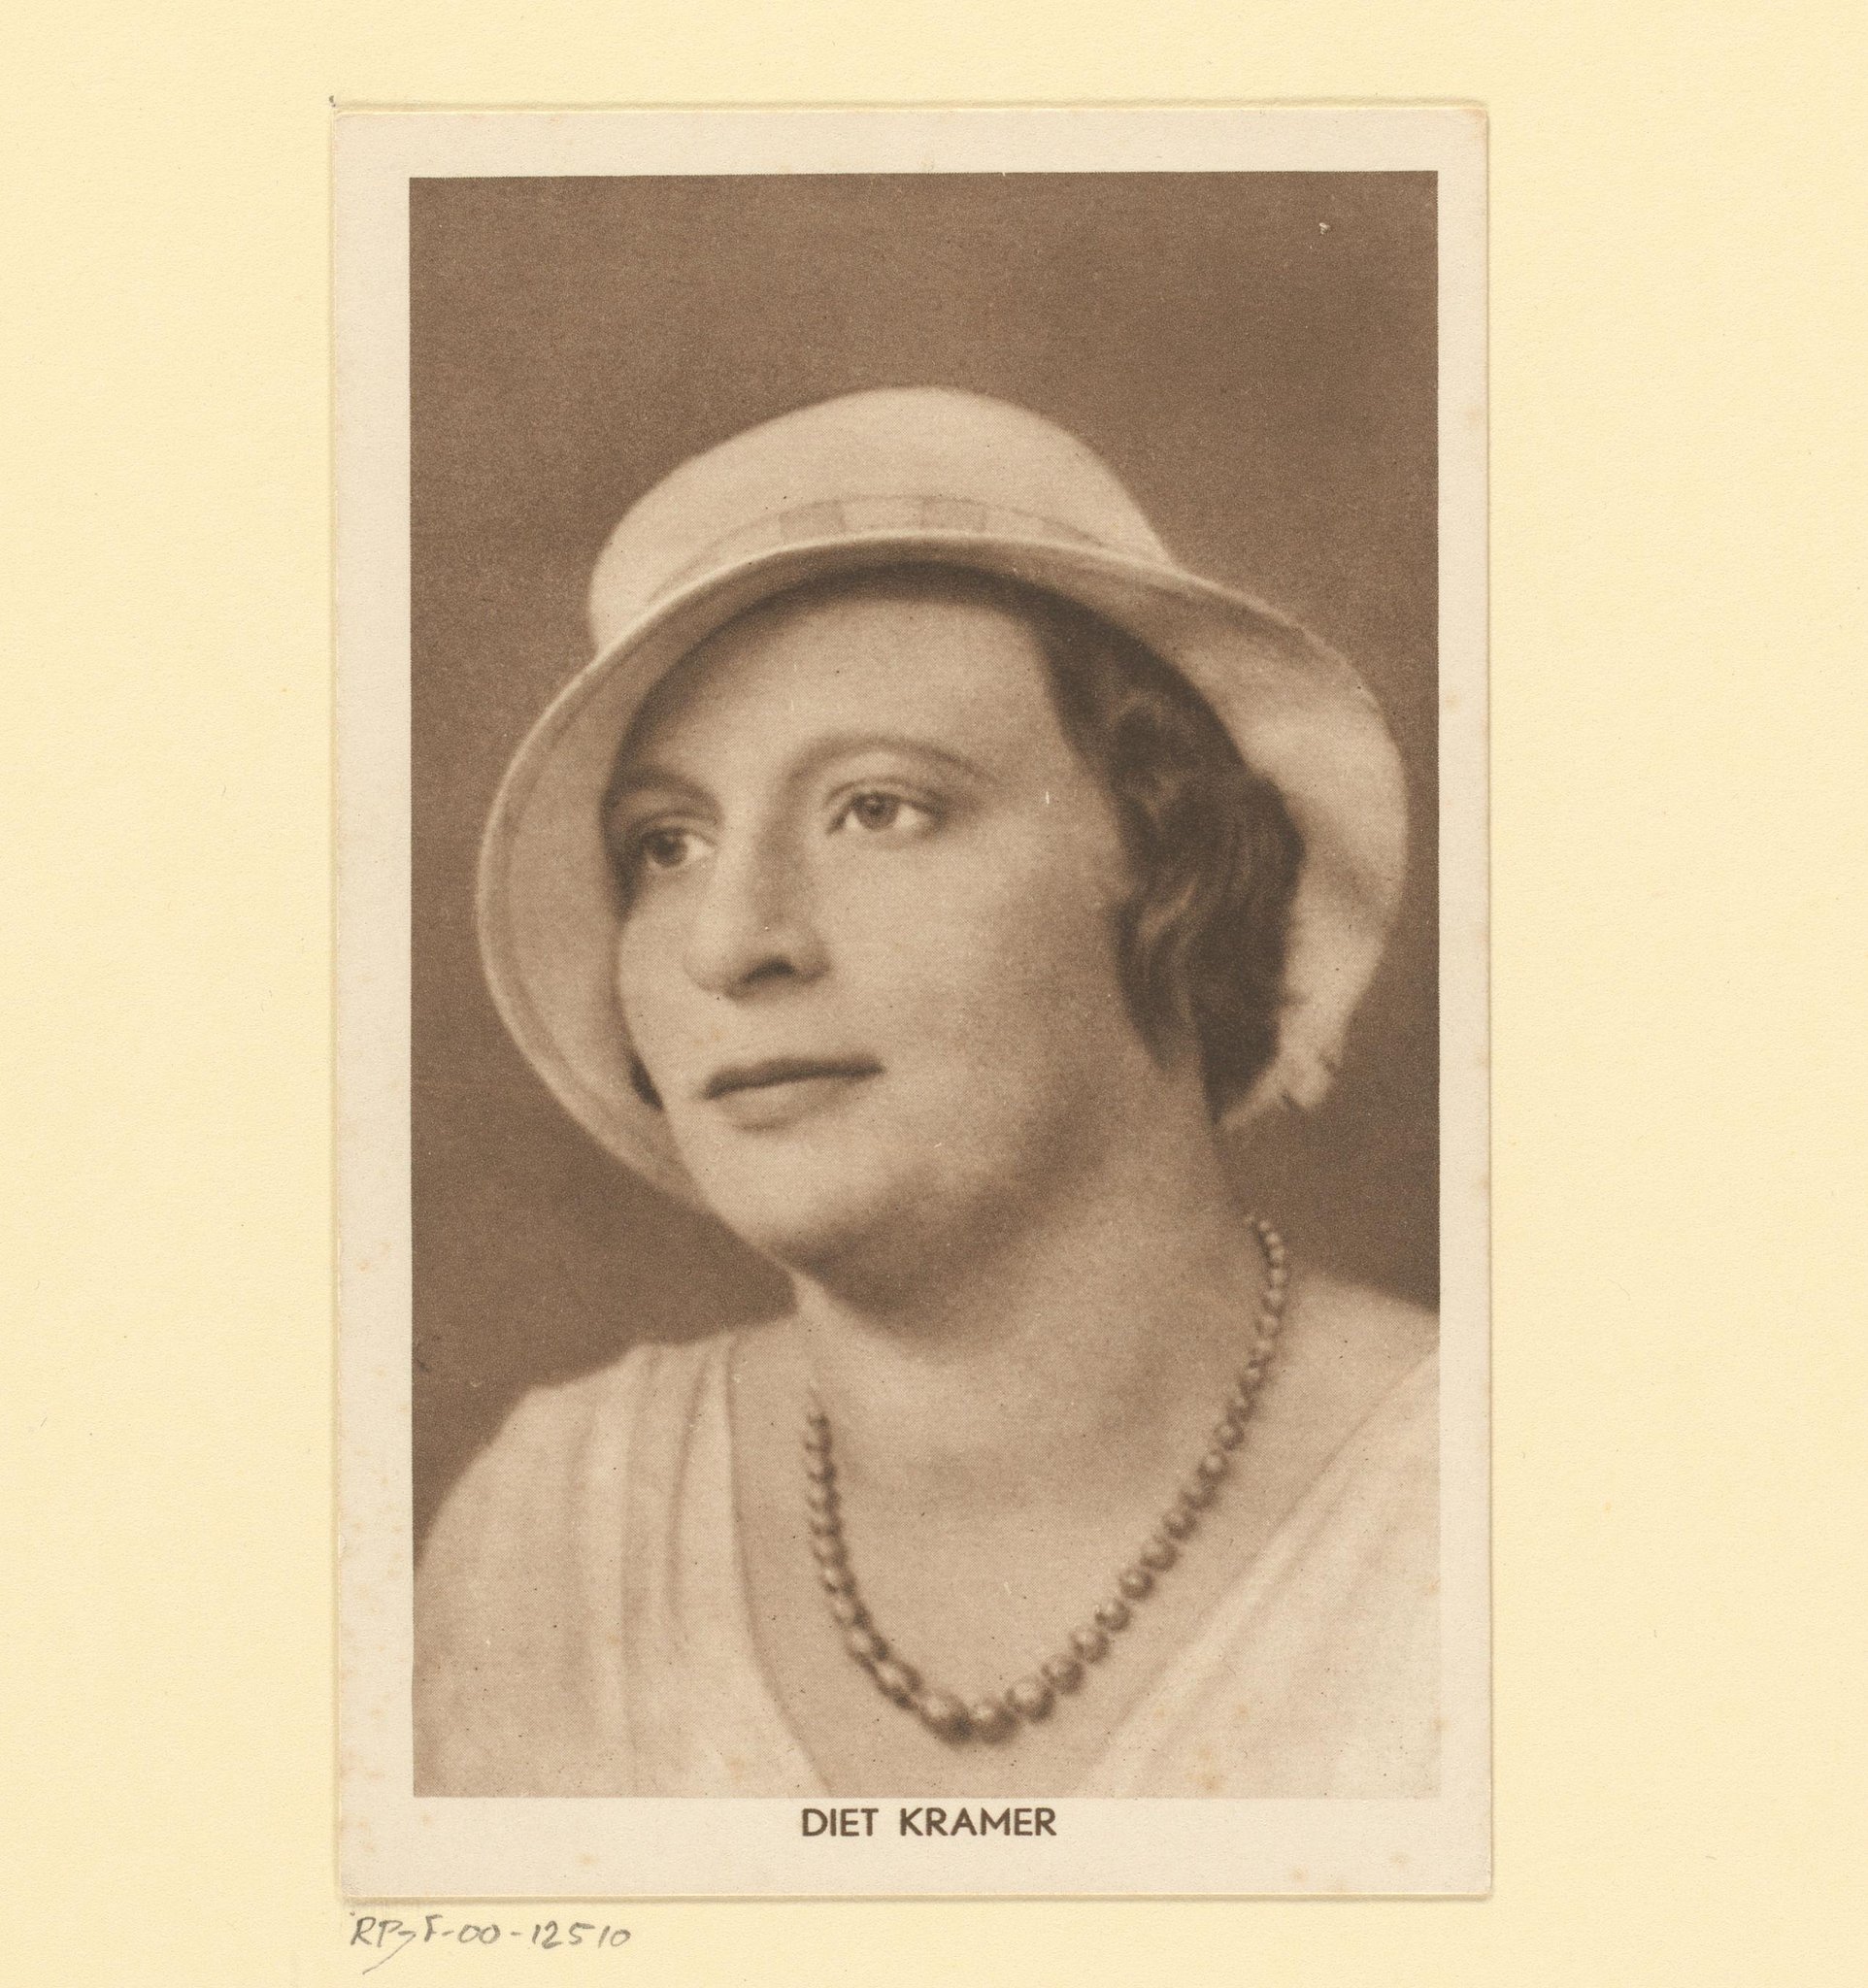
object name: photomechanical print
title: Diet Kramer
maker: Anonymous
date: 1934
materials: cardboard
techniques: rotogravure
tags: amsterdam, the hague, historical persons - bb - woman